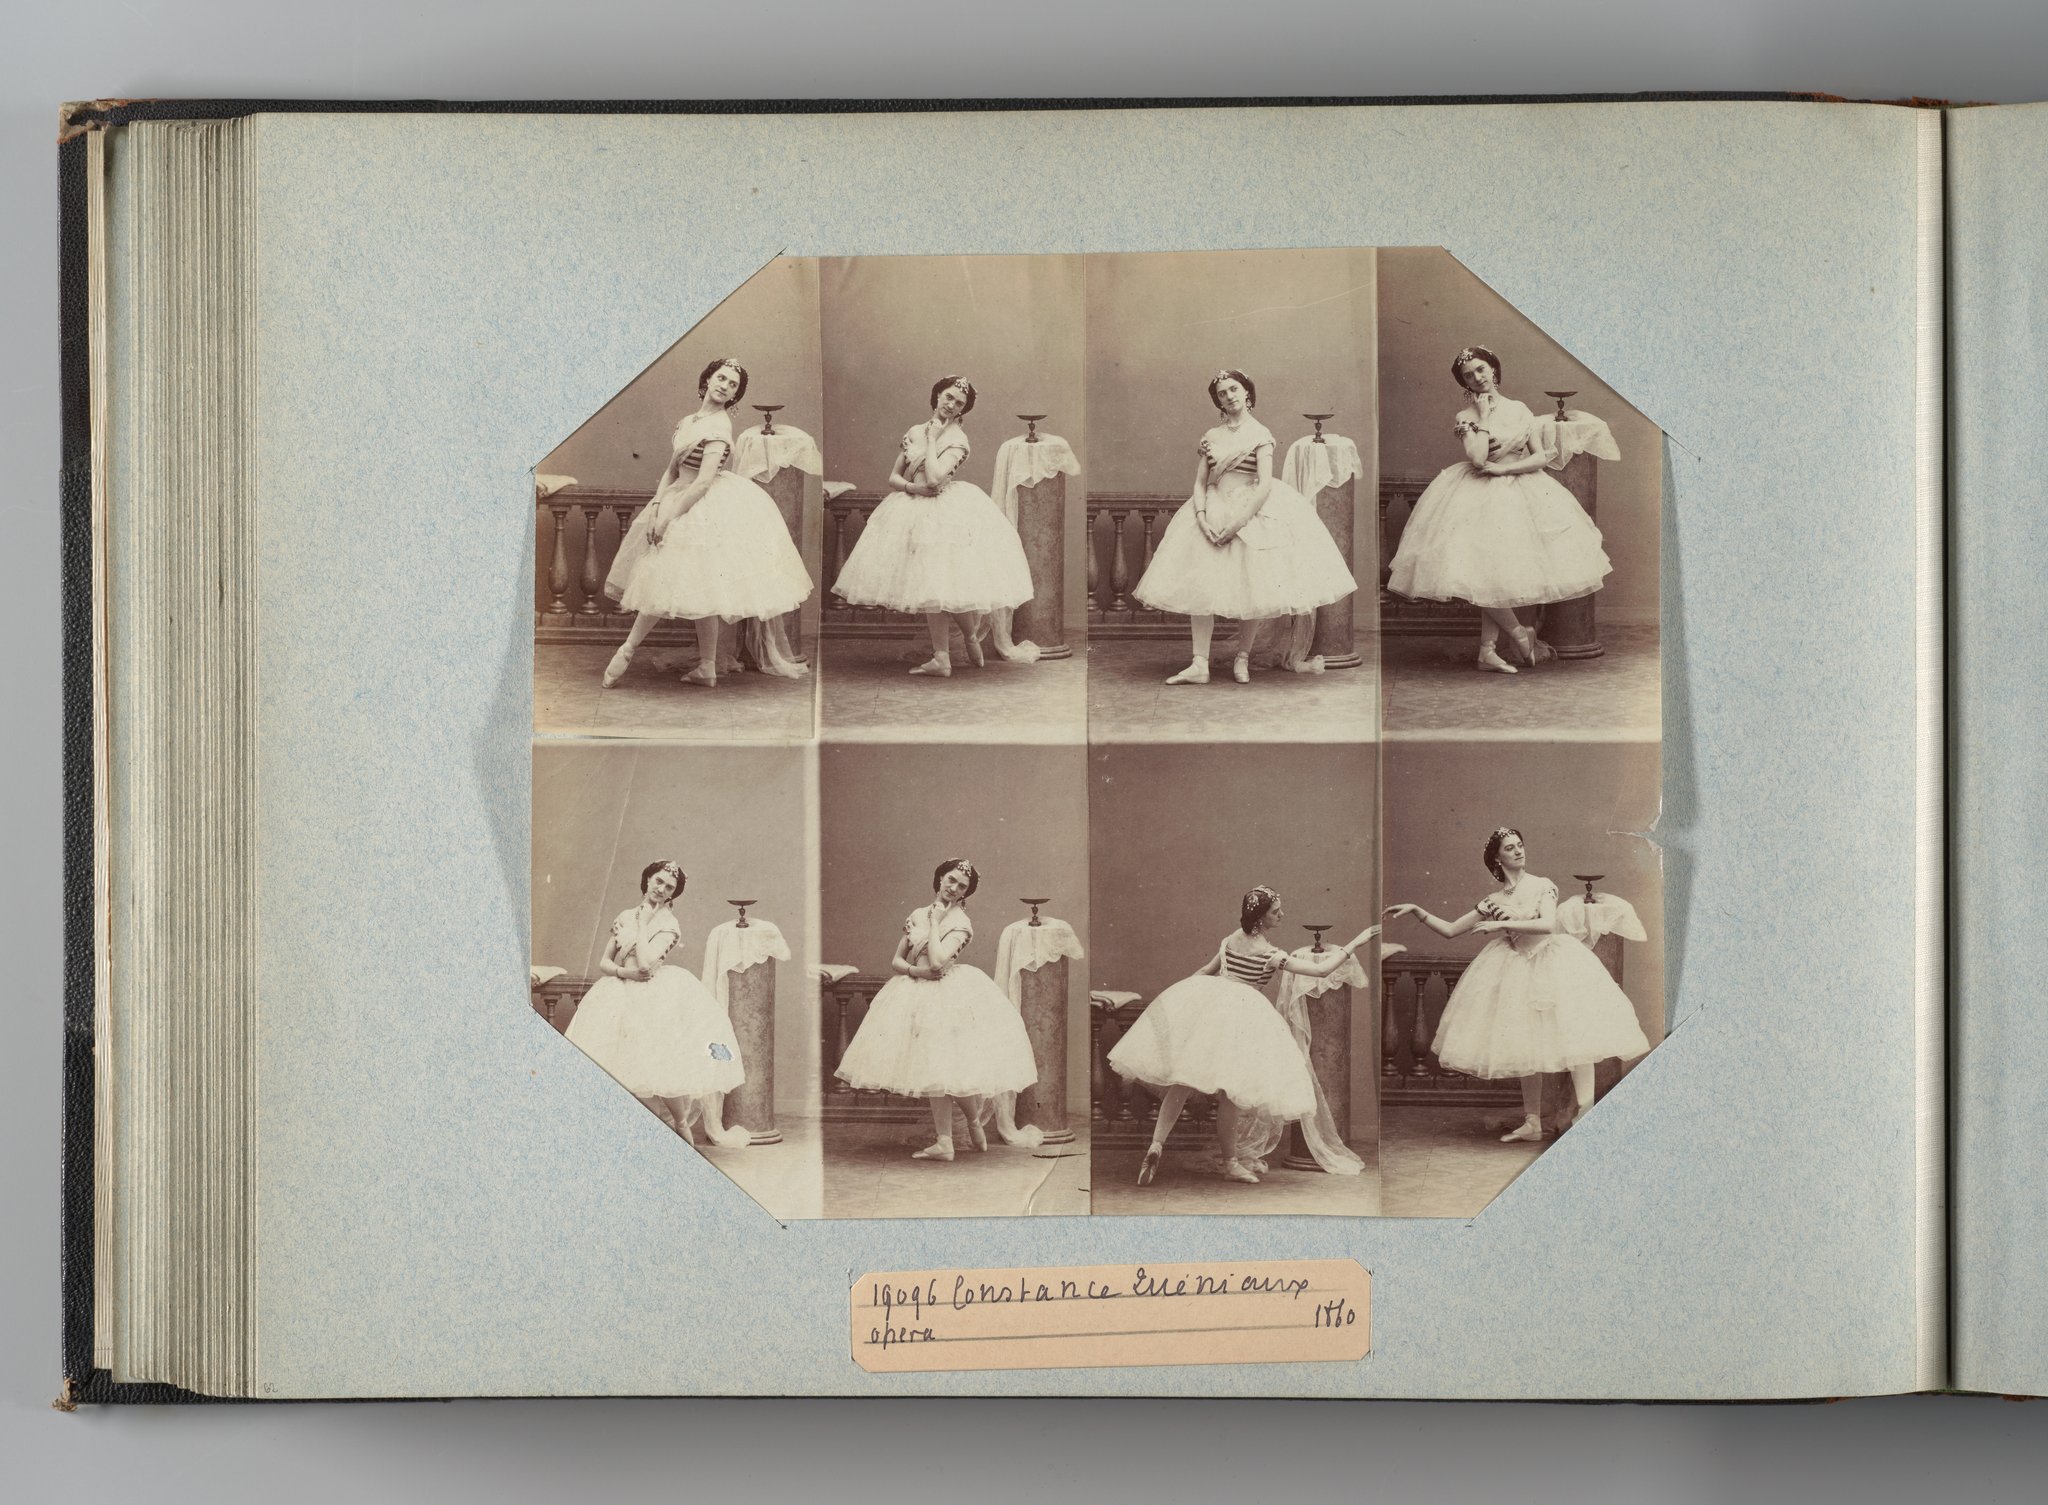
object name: photograph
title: Constance Queniaux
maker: andré-adolphe-eugène disdéri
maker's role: artist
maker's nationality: french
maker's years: 1819-1889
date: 1860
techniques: albumen silver print, glass negative